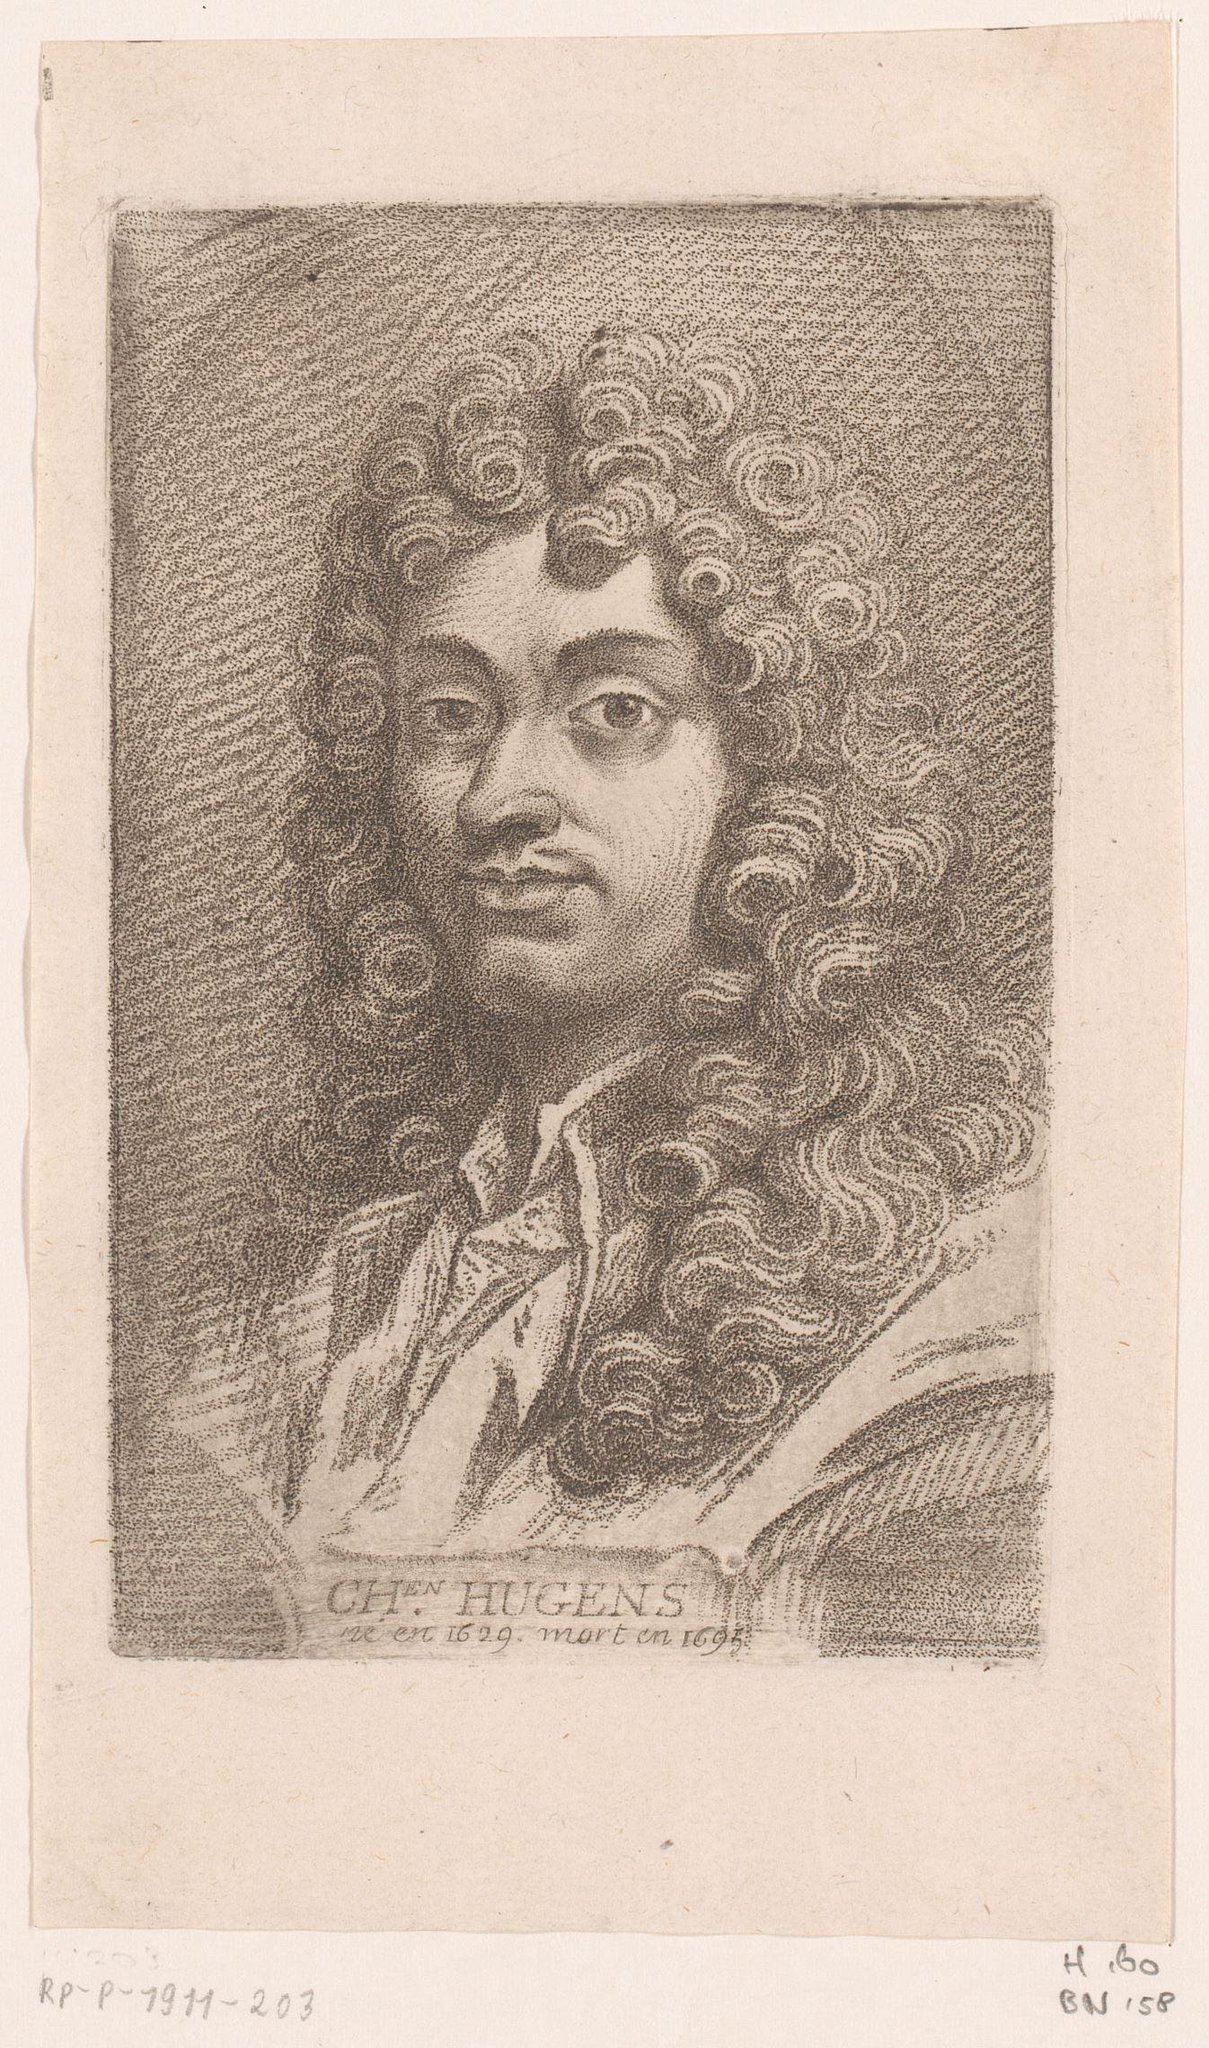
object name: book illustration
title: Portret van Christiaan Huygens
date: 1760-1769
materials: paper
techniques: printmaking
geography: france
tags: the hague, draughtsman, physicist, christiaan huygens (ii), historical persons, portrait of a writer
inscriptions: collector's mark: Lugt 2228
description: Prent uit: Saverien, Alexandre. L'Histoire des Philosophes modernes, avec leur portrait gravé dans le goût du crayon, d'apres les desseins des plus grands peintres. Parijs: Jean Charles François, 1760-1761.